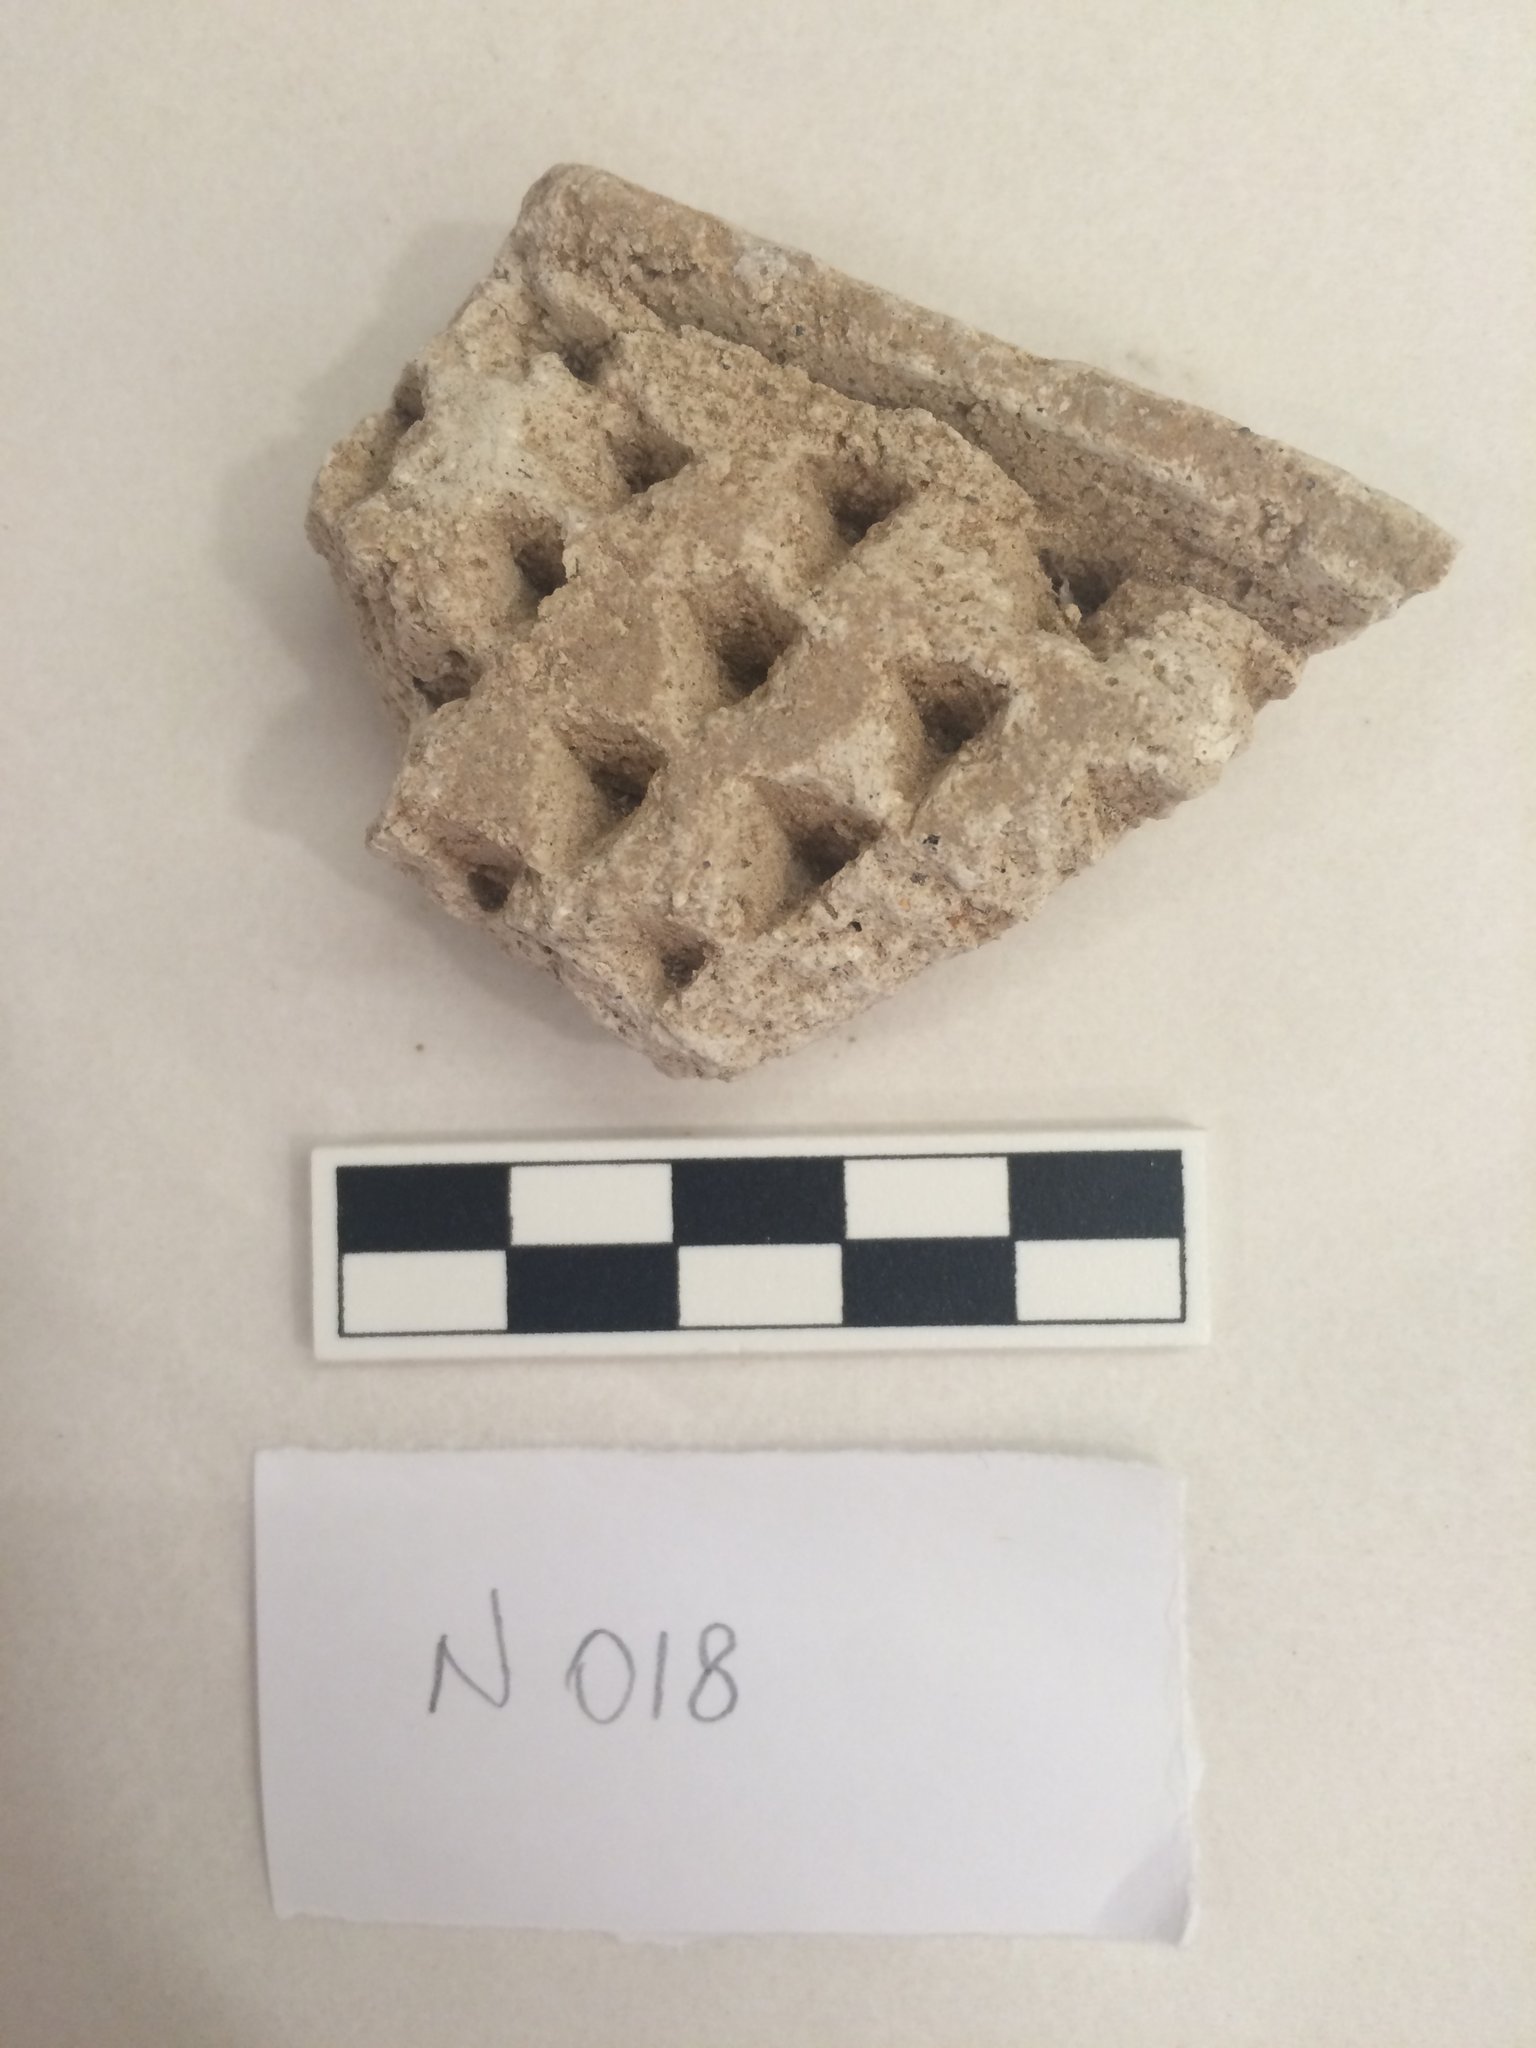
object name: fragment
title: Stucco Fragment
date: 701-1200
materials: plaster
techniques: carving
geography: iran